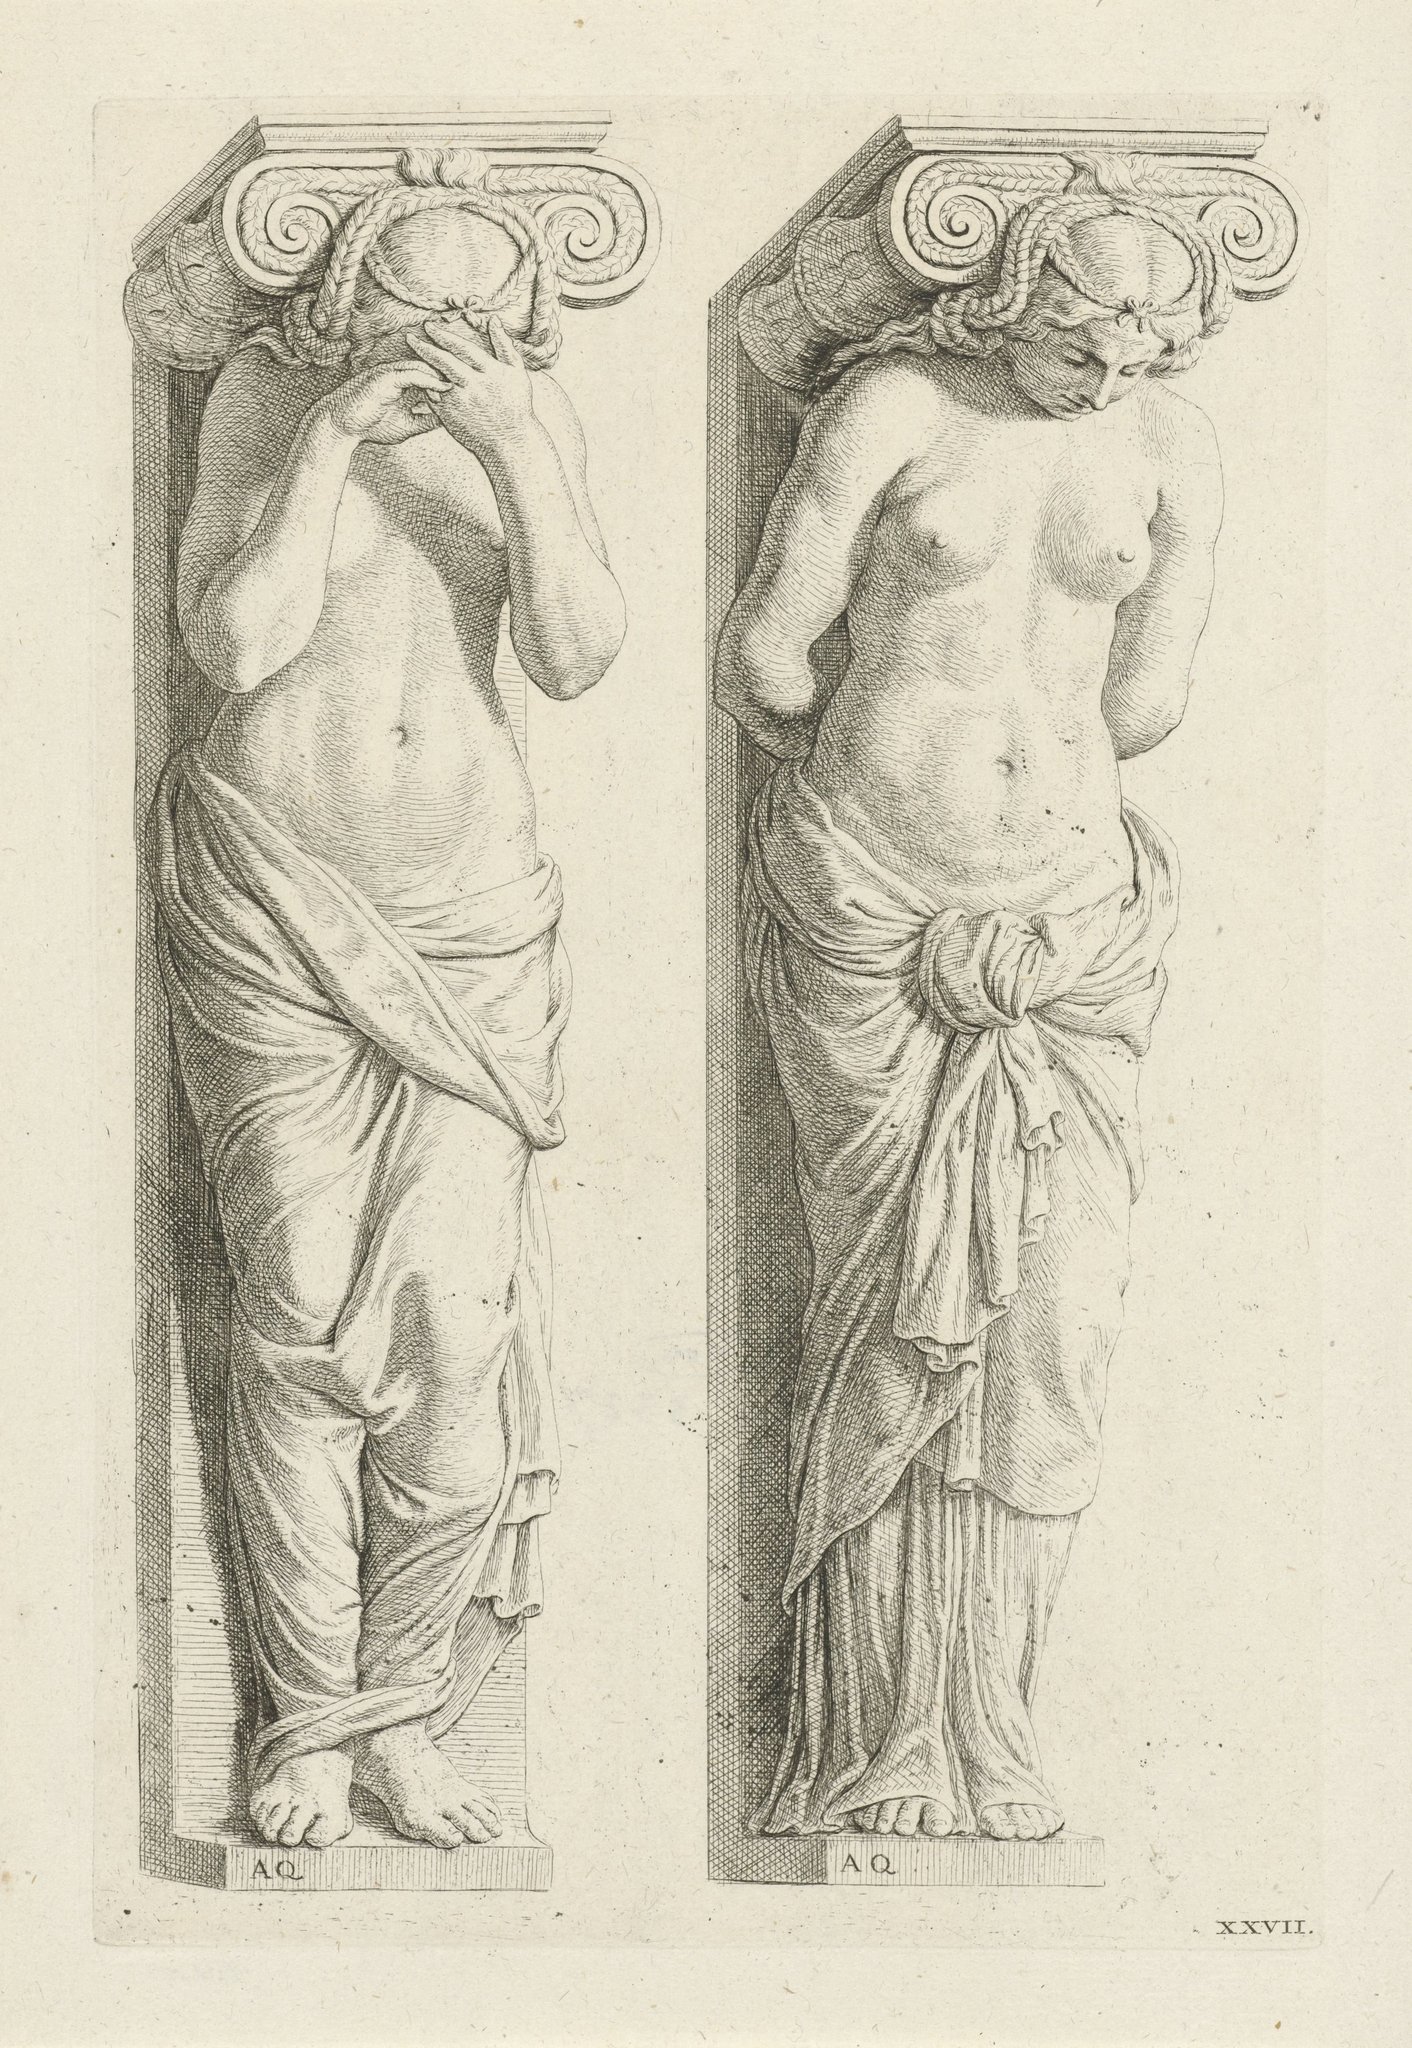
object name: book illustration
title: De twee linker kariatiden uit de Vierschaar van het Stadhuis op de Dam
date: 1655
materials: paper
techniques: engraving, etching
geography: amsterdam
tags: caryatids ~ architecture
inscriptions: collector's mark: Lugt 2228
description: Huidige staat van prent ook gebruikt in: Architecture peinture et sculpture de la Maison de Ville d'Amsterdam, representee en CIX. figures en taille-douce (…). Amsterdam: David Mortier, 1719. En in: Architecture peinture et sculpture de la Maison de Ville d'Amsterdam, representee en CIX. figures en taille-douce (…). Amsterdam: Gerard Valck, 1719. En in: Bouw schilder en beeldhouwkonst, van het Stadhuis te Amsteldam, vertoont in CIX figuuren (…). Amsterdam: Covens & Mortier & Covens Jr., s.a. (1774-1783). Eerdere staat van prent ook gebruikt in: Prima pars. Praecipuarum effigierum ac ornamentorum, amplissimae Curiae Amstelrodamensis (…) / Het eerste deel. Van de voornaemste Statuen ende Ciraten, vant konstijck Stadhuys van Amstelredam, tmeeste in marmer gemaeckt, door Artus Quellinus, Beelthouwer der voorseyde Stadt / La Premier Partie. De plusieurs Figures et ornements, de la Maison de Ville d'Amsterdam (…). Amsterdam: Artus Quellinus (I), 1655. En in: Prima pars. Praecipuarum effigierum ac ornamentorum, amplissimae Curiae Amstelrodamensis (…) / Het eerste deel. Van de voornaemste Statuen ende Ciraten, vant konstijck Stadhuys van Amstelredam, tmeeste in marmer gemaeckt, door Artus Quellinus, Beelthouwer der voorseyde Stadt / La Premier Partie. De plusieurs Figures et ornements, de la Maison de Ville d'Amsterdam (…). Amsterdam: Frederik de Wit, 1665. Zie BK-AM-51-24-A-1, BK-AM-51-24-A-2, BK-AM-51-24-B-1 en BK-AM-51-24-B-2 voor modellen van de beelden van de kariatiden.